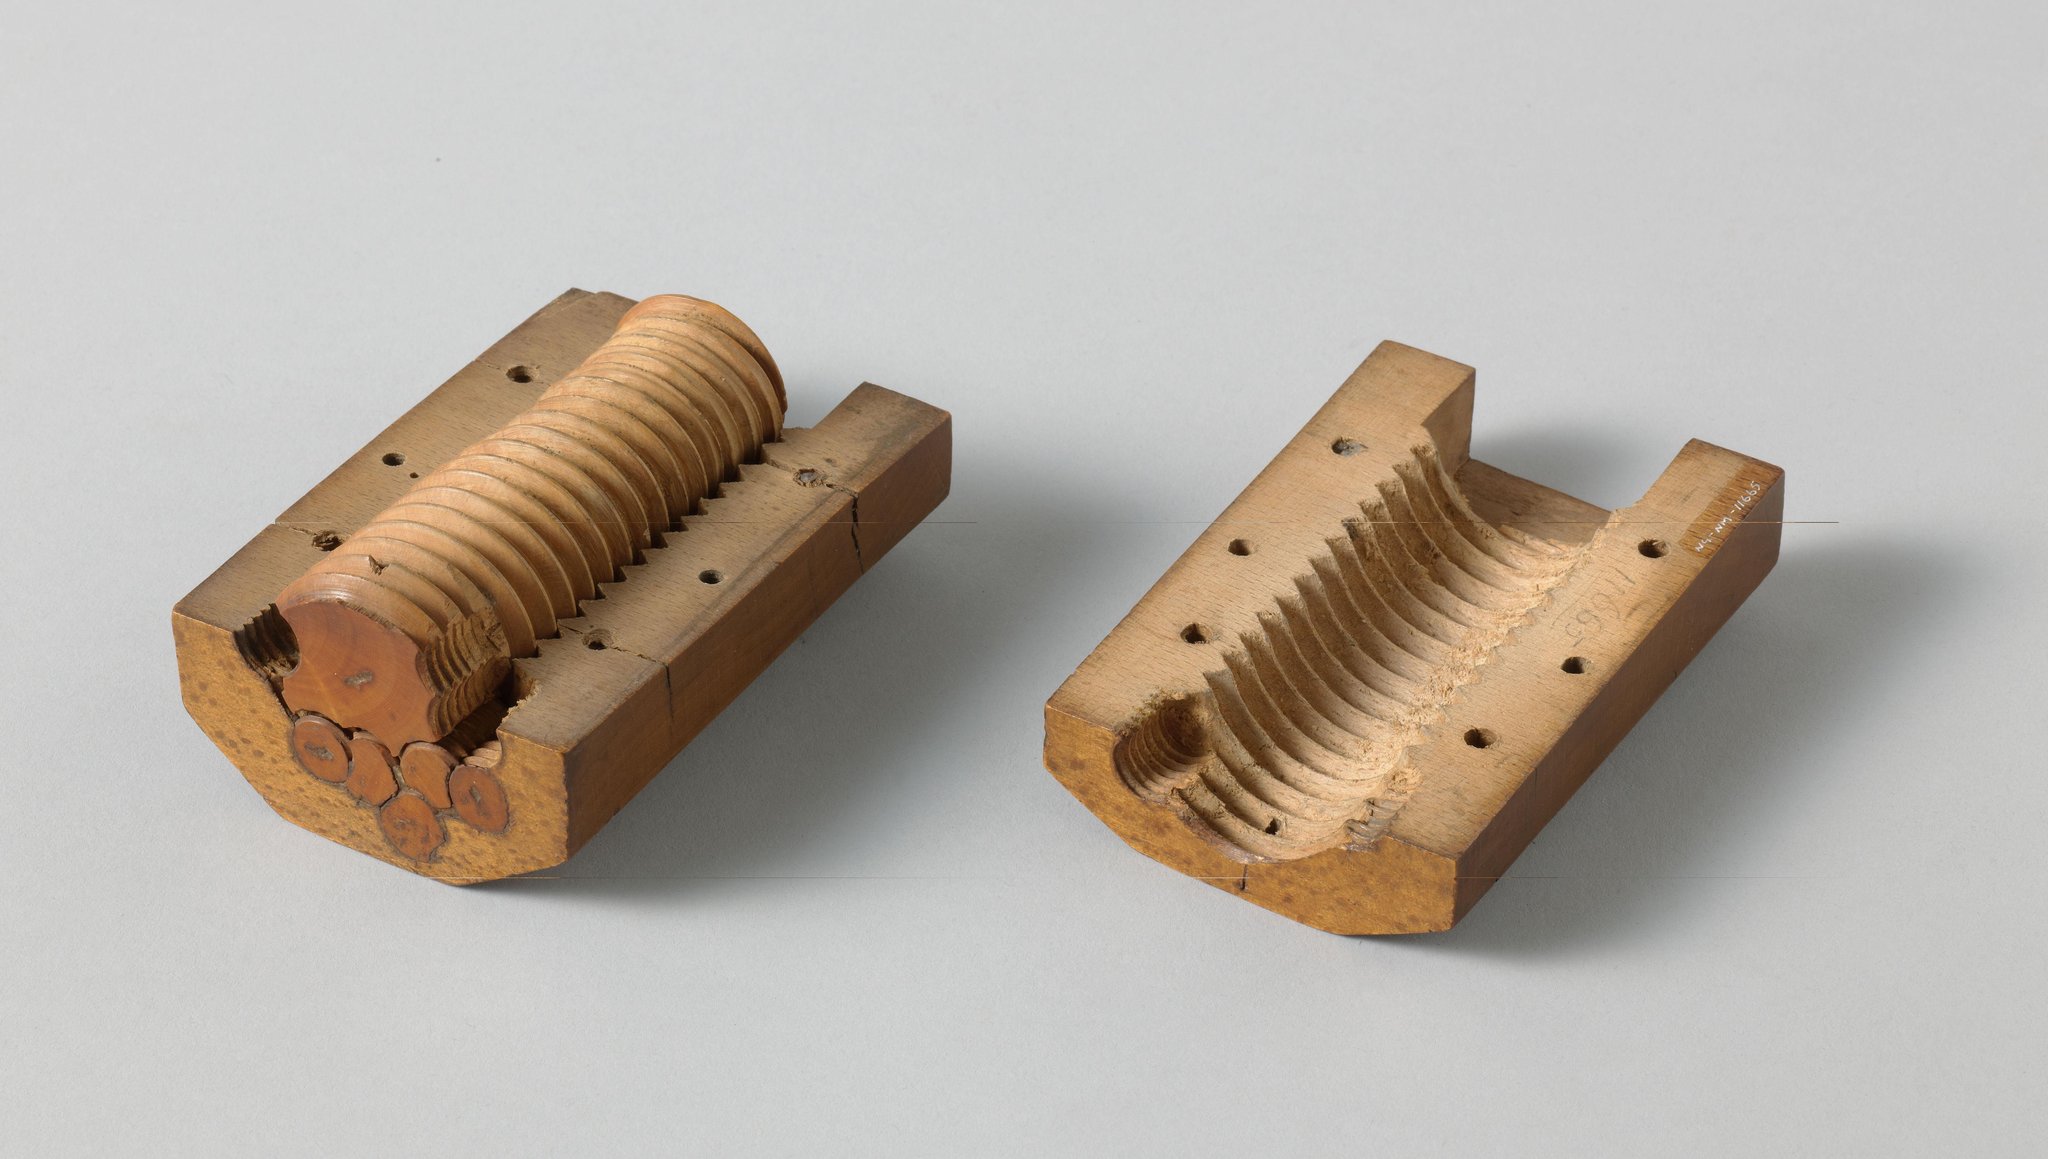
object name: scale model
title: Model dat laat zien hoe gallen in kanonnen gestopt kunnen worden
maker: jan verbruggen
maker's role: geschutgieter, ijzergieter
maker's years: 1712-1781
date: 1760-1762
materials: wood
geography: the hague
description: Beukenhouten model met palmhouten schroeven, dat laat zien op welke manier gallen (luchtgaten die ontstaan bij het gieten van ijzer) in kanonnen gestopt kunnen worden. Waarschijnlijk behorende bij bescheiden in het Rijksarchief, betrekking hebbende op het stoppen van gallen in kanonnen, die gegoten werden door de grofgeschutgieter Jan Verbruggen in 's Gravenhage.